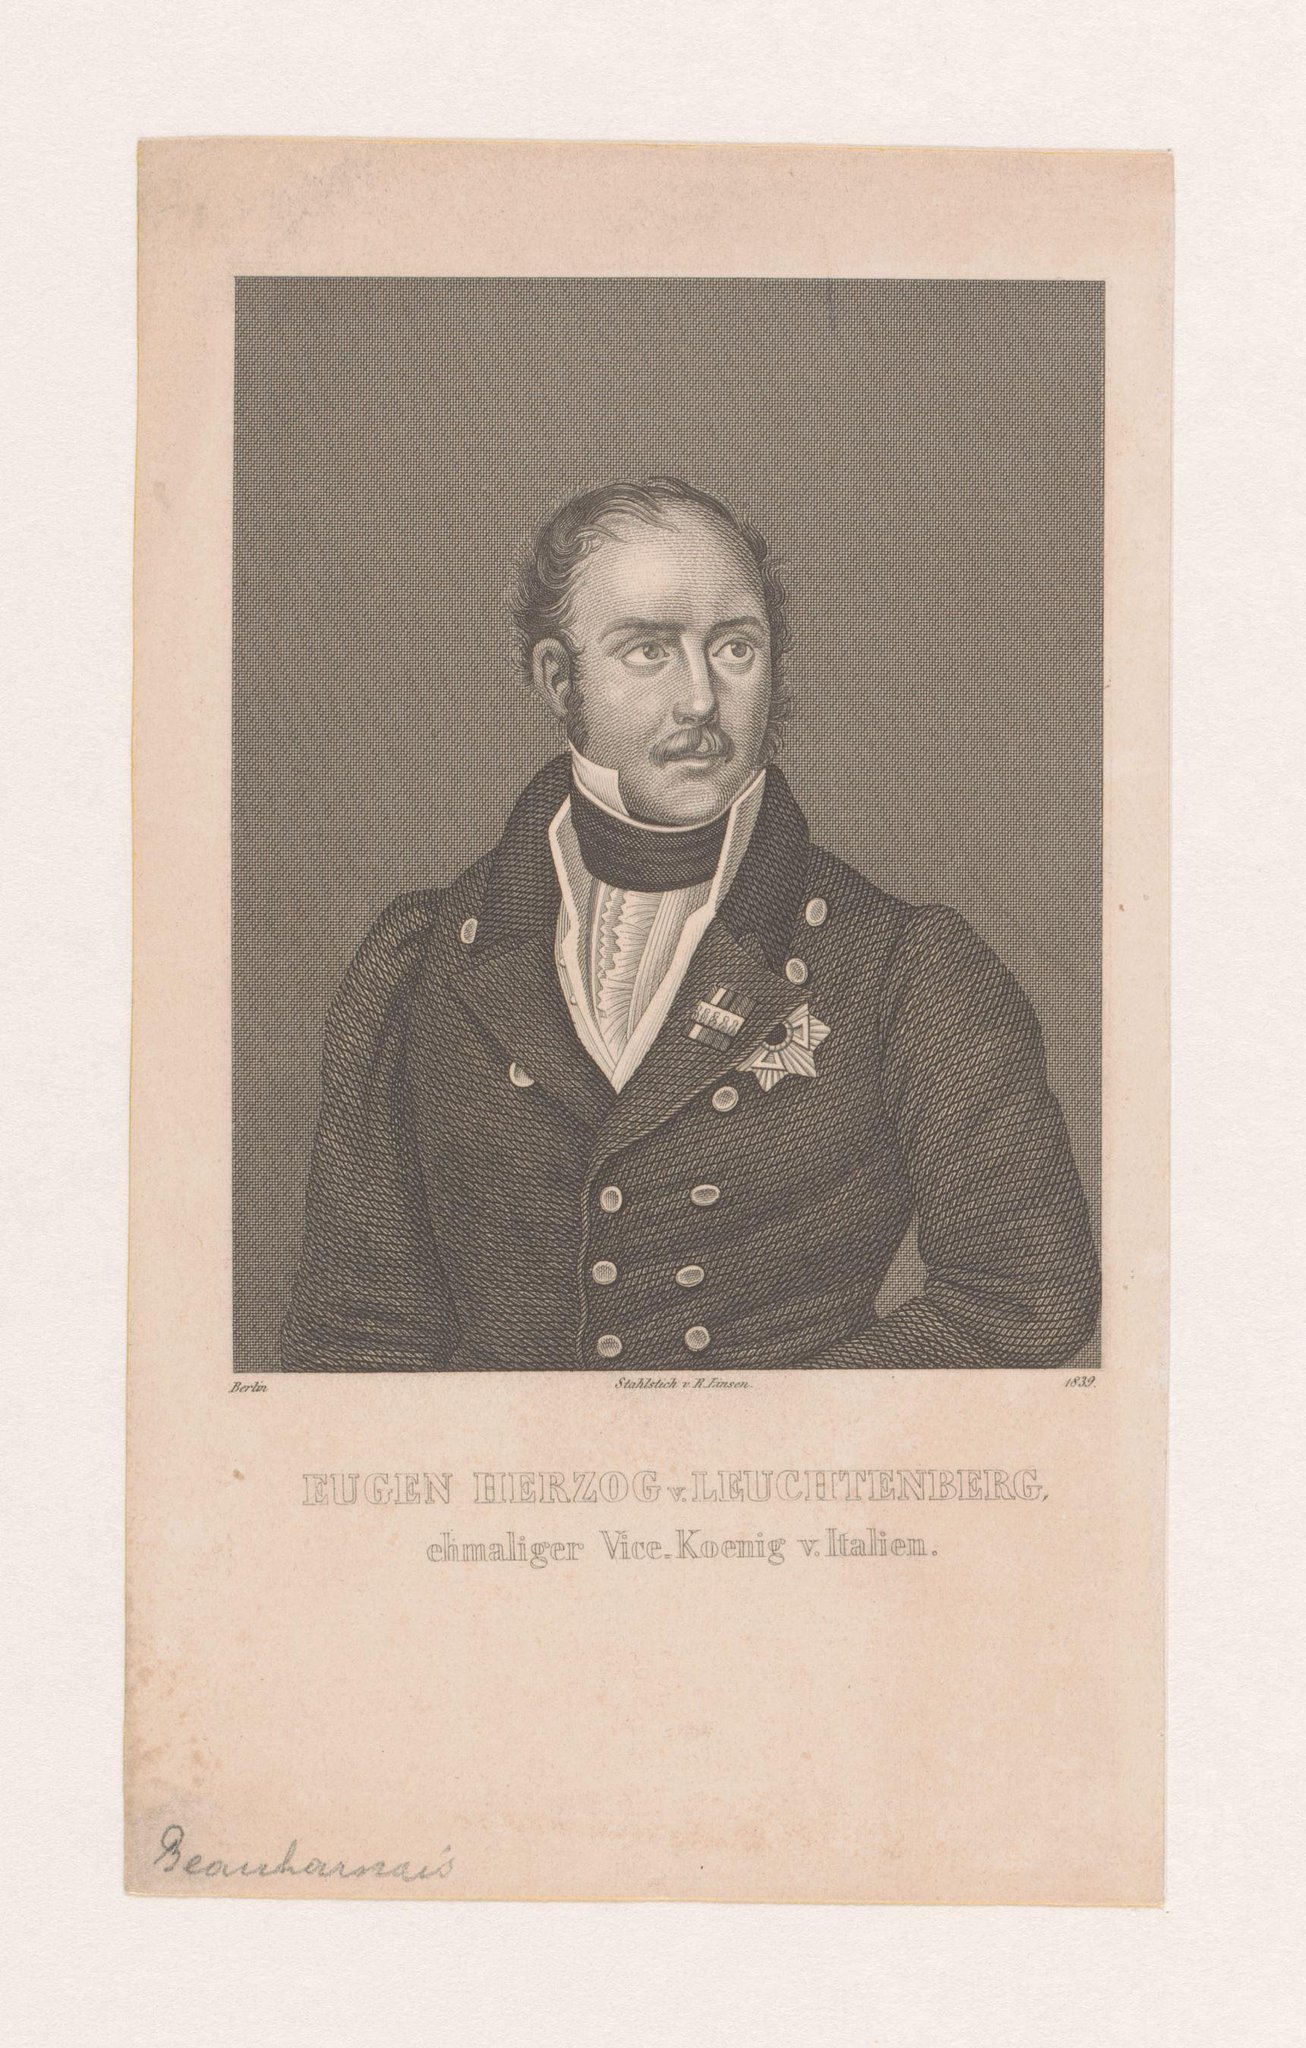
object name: print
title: Portret van Eugène de Beauharnais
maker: r. linsen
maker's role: print maker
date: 1839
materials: paper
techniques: engraving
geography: berlin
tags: eugène de beauharnais, commander-in-chief, general, marshal, historical persons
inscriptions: collector's mark: Lugt 2228